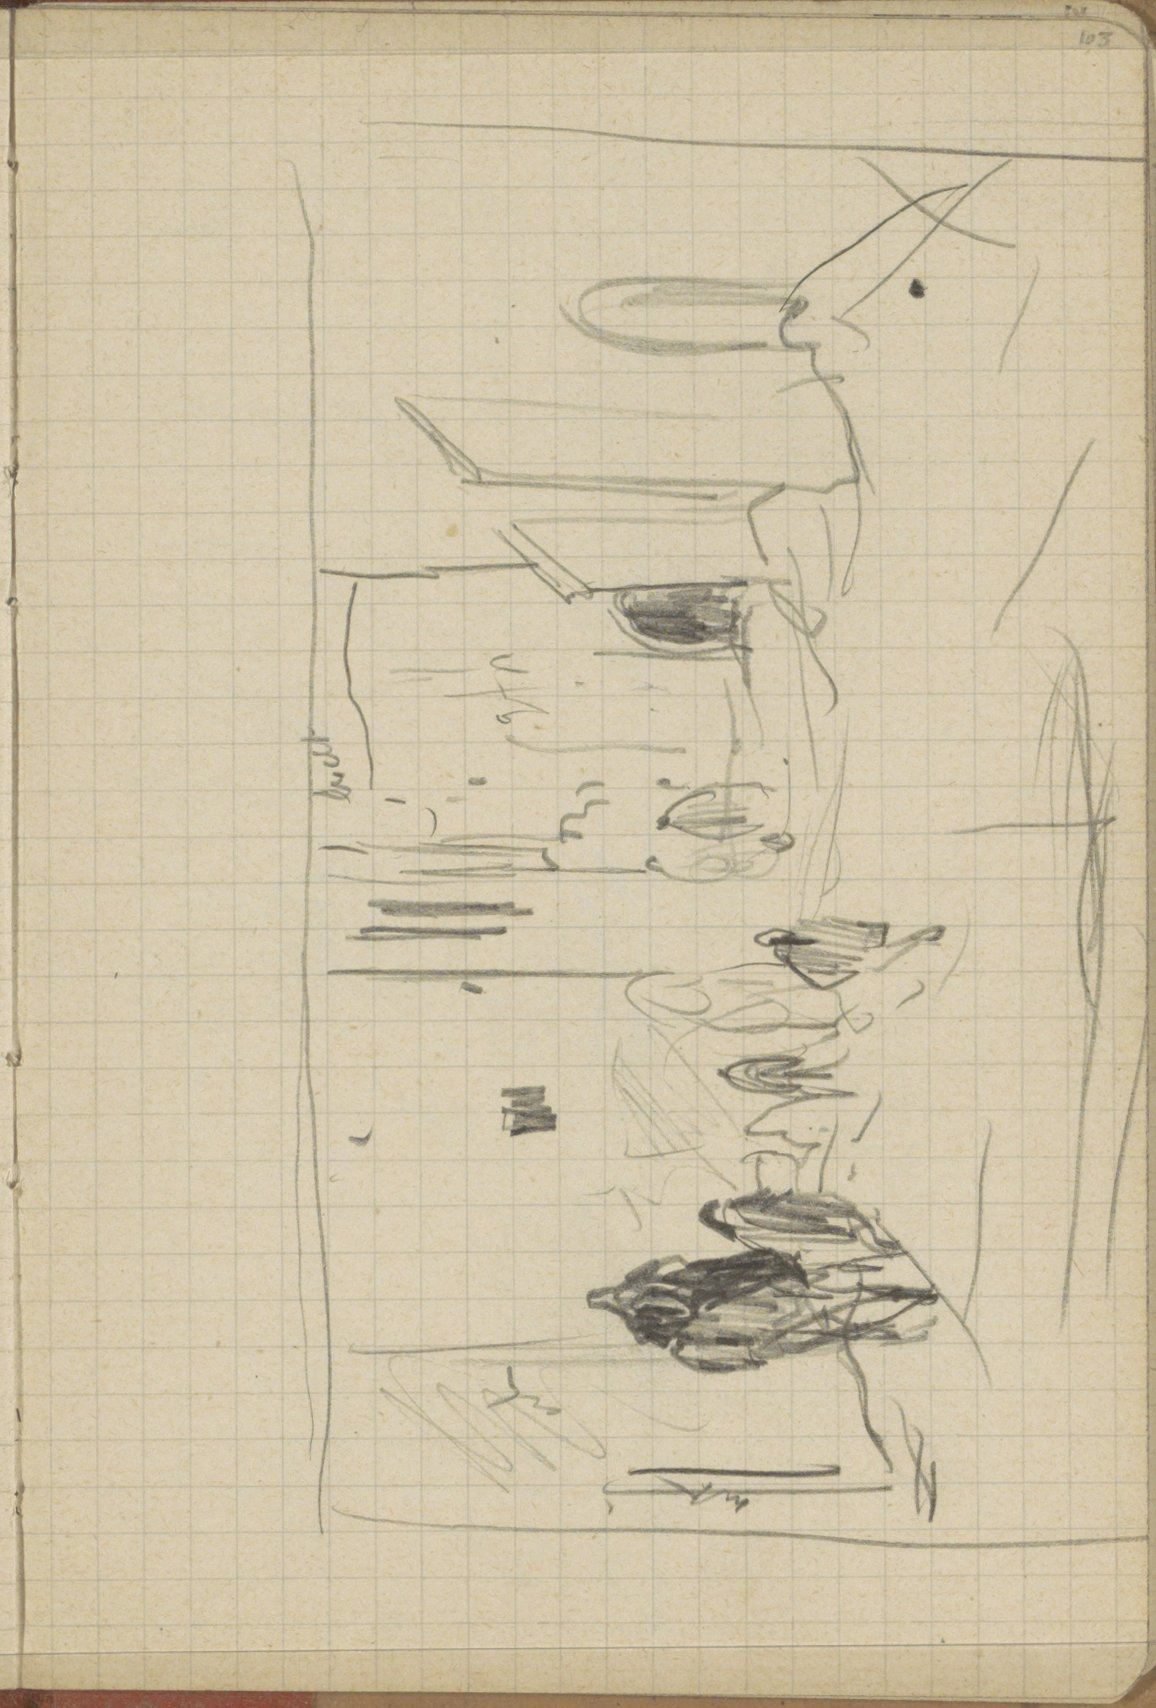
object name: sketchbook leaf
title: Straat met figuren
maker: marius bauer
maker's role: draughtsman, print maker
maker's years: 1867-1932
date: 1909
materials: pencil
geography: tunisia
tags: street (+ city(-scape) with figures, staffage)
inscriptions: kleurnotitie, handgeschreven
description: Pagina 103 uit een schetsboek met 67 bladen.